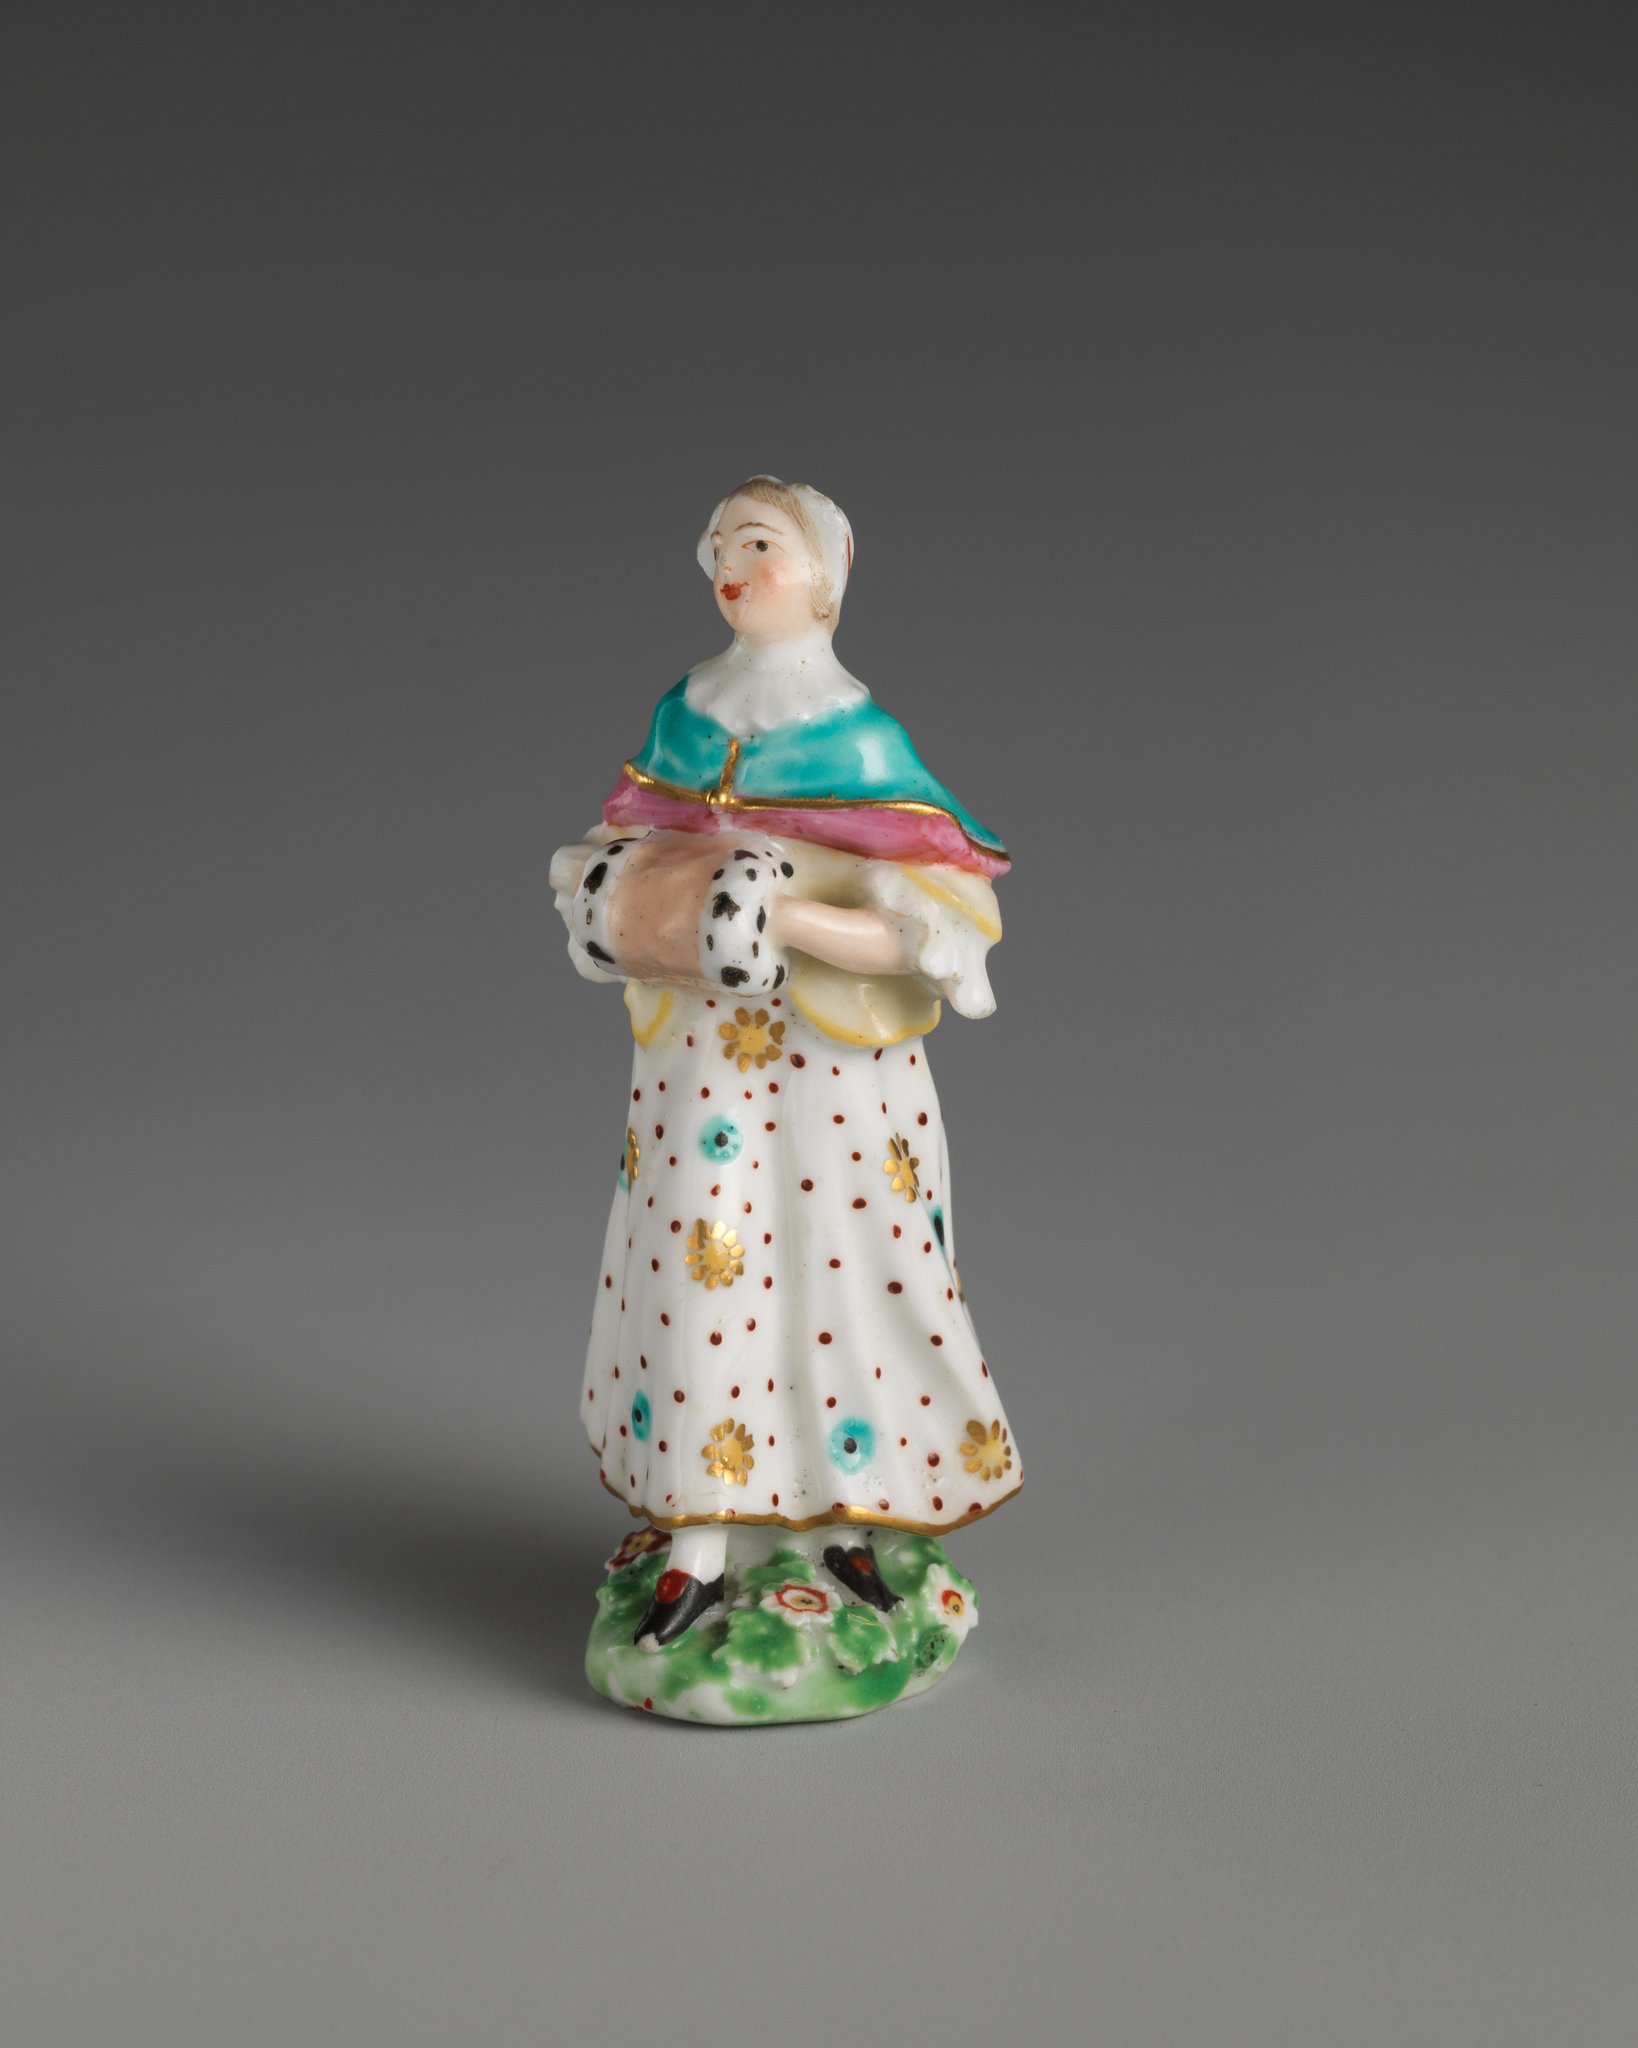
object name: toy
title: Lady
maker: derby porcelain manufactory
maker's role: factory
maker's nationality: british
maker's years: 1751-1785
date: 1765-1768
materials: soft paste porcelain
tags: women